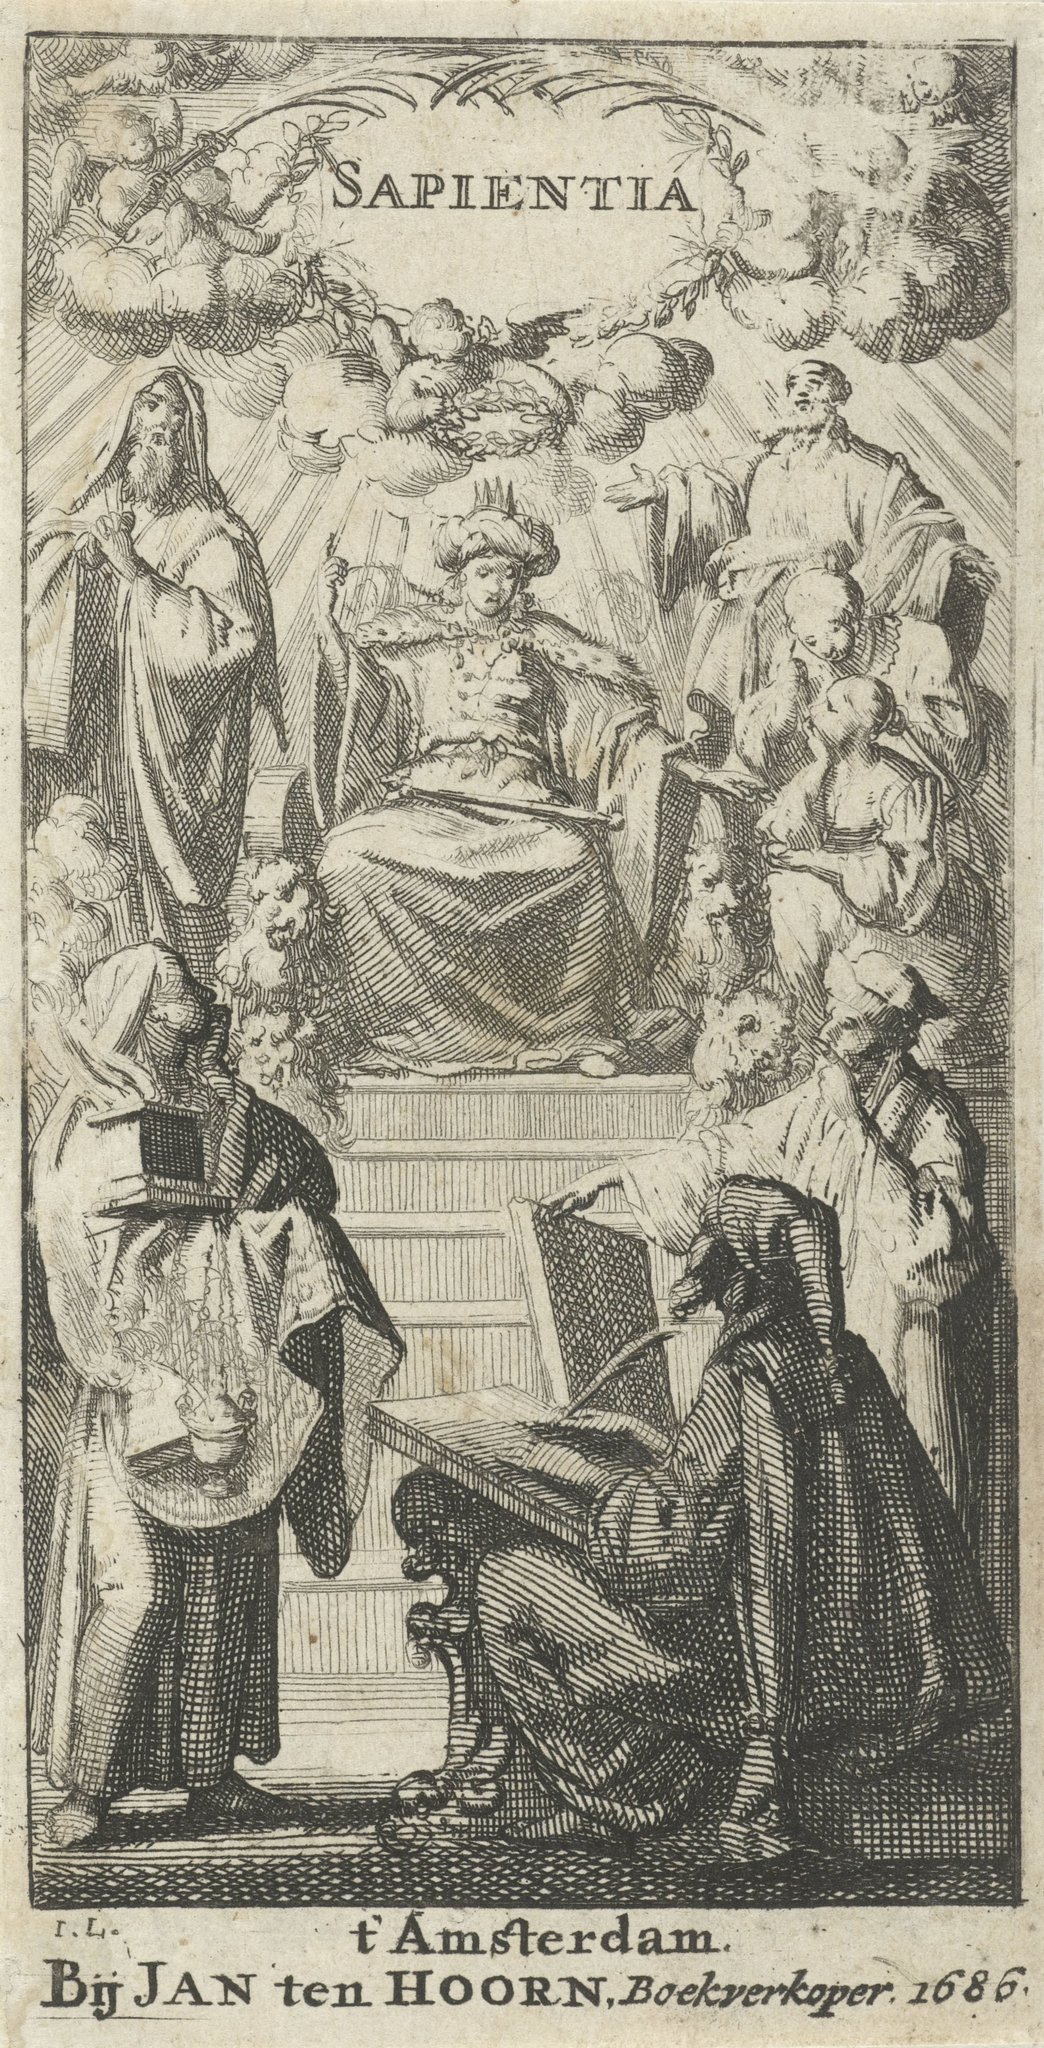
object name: print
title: Titelpagina voor: H. Ram, Wĳsheyds lessen, ofte Salomons by-een-gebrachte grond-regelen, 1686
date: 1686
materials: paper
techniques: etching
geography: amsterdam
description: Titelpagina voor: Ram, Henry. Wĳsheyds lessen, ofte Salomons by-een-gebrachte grond-regelen. Amsterdam: Jan Claesz ten Hoorn, 1686.